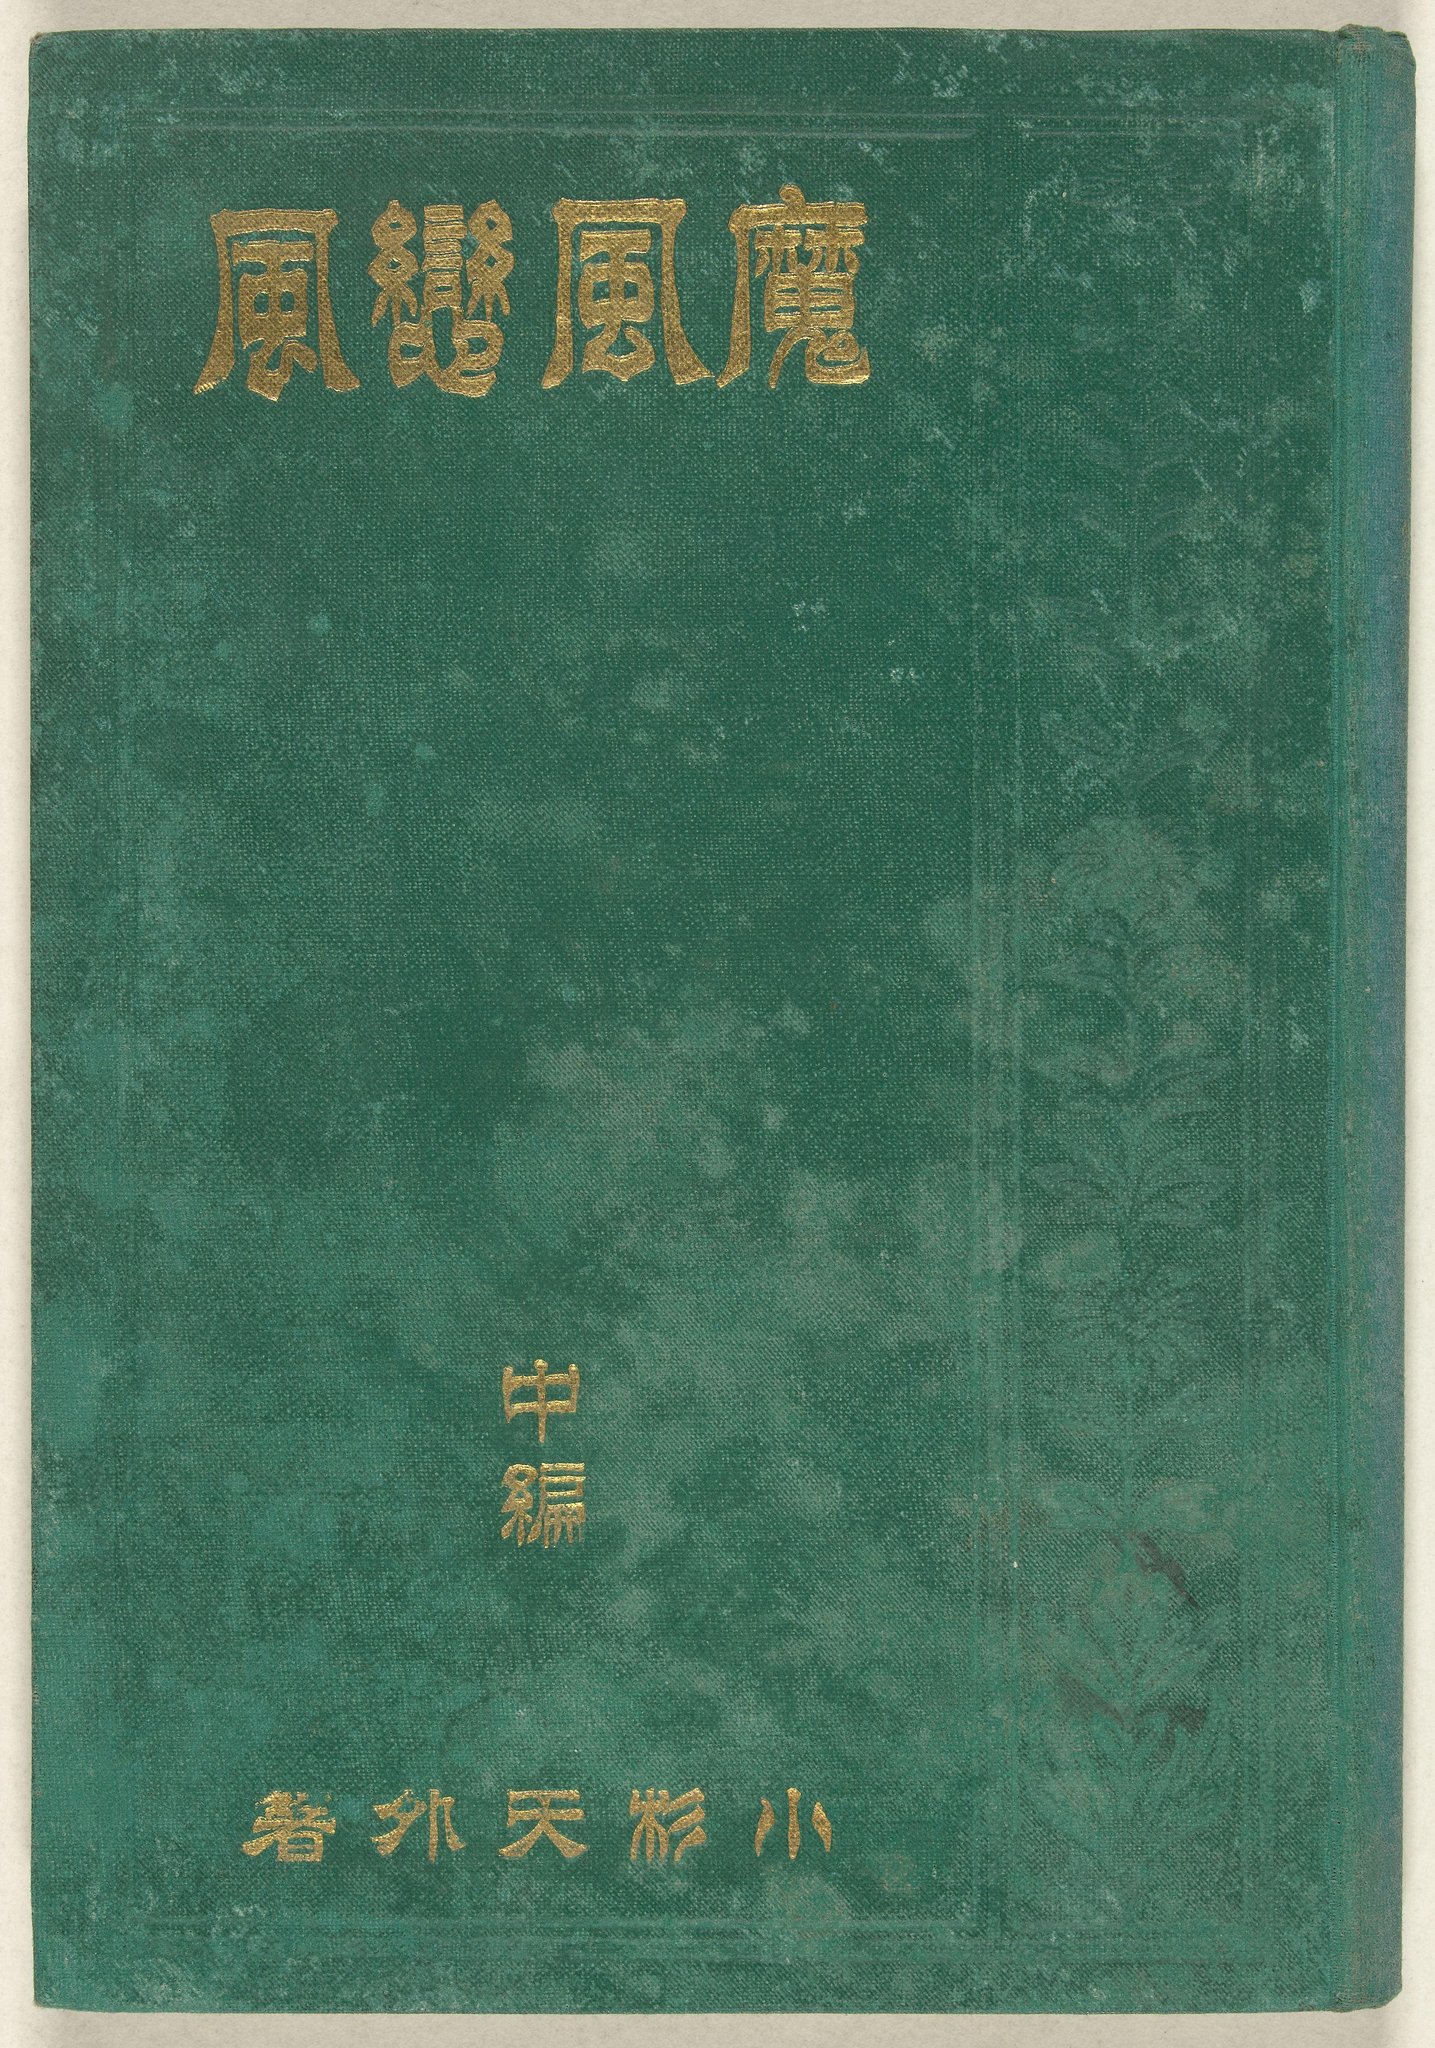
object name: book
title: Makaze koikaze - chuhen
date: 1907-1908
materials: paper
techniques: woodcut, letterpress printing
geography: tokyo